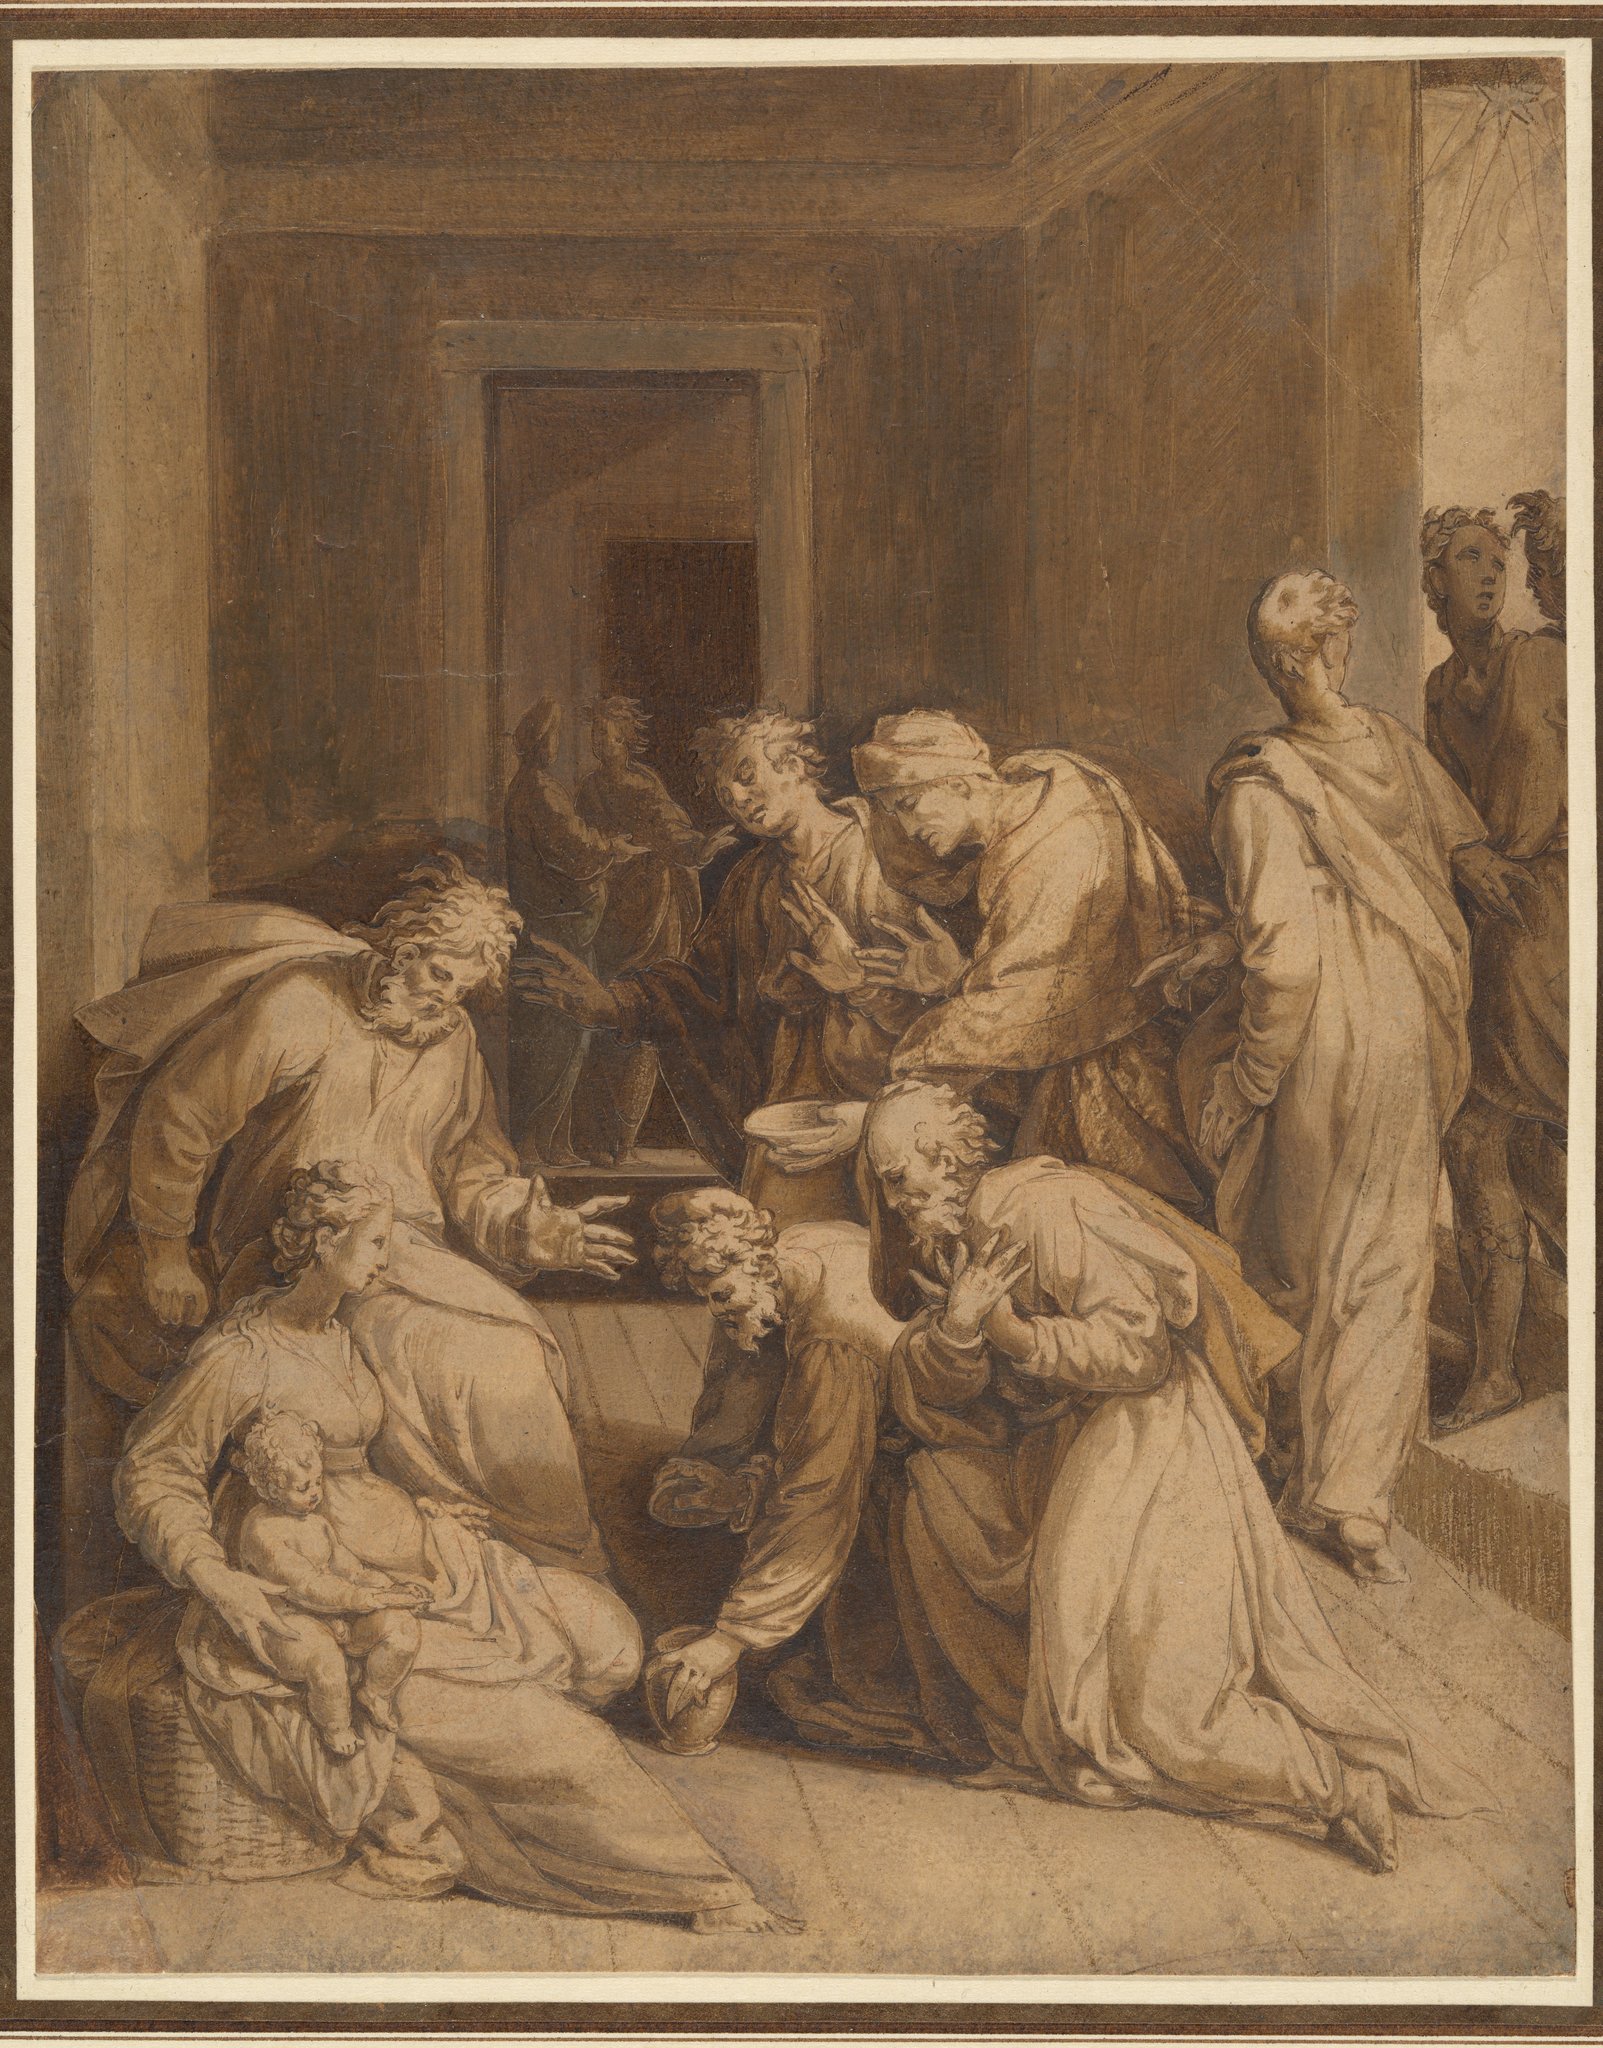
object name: drawing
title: The Adoration of the Magi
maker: adriaan de weerdt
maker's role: draughtsman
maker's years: 1510-1590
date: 1573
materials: chalk, oil, paper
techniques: brush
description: After the birth of Jesus, the three Magi – the ‘wise men from the East’ – followed the star of Bethlehem, visible at the upper right, to find the newborn infant. If you look closely, you will notice that the contours of all the figures have been incised. These thin lines are the remains of the process of tracing, used to transfer the composition onto a copper plate.